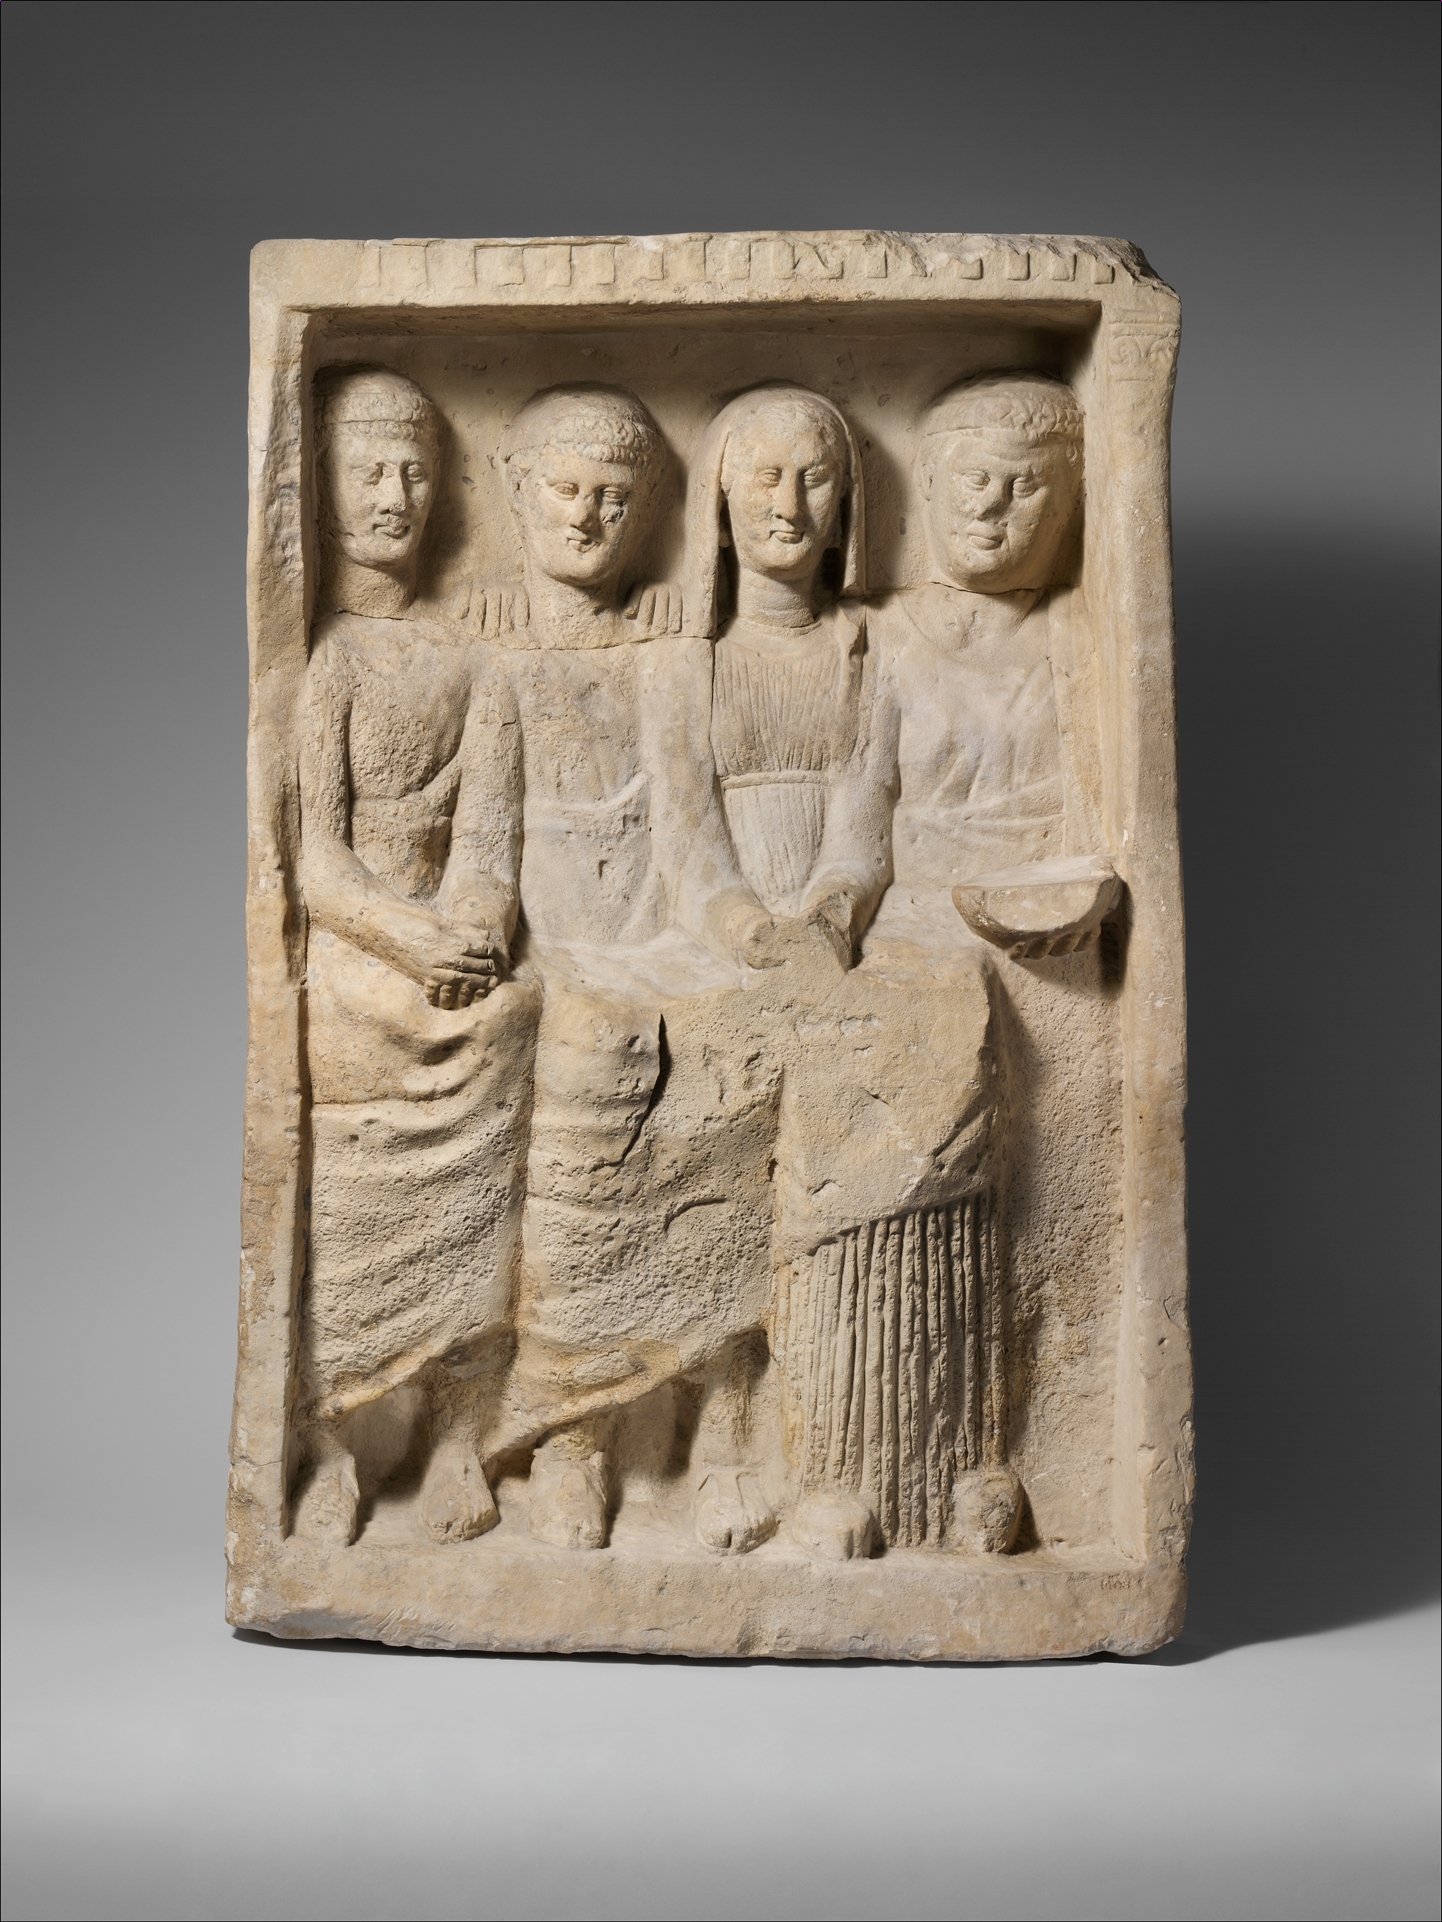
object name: grave relief with four figure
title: Limestone funerary monument with four figures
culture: cypriot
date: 1-100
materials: limestone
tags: men,women